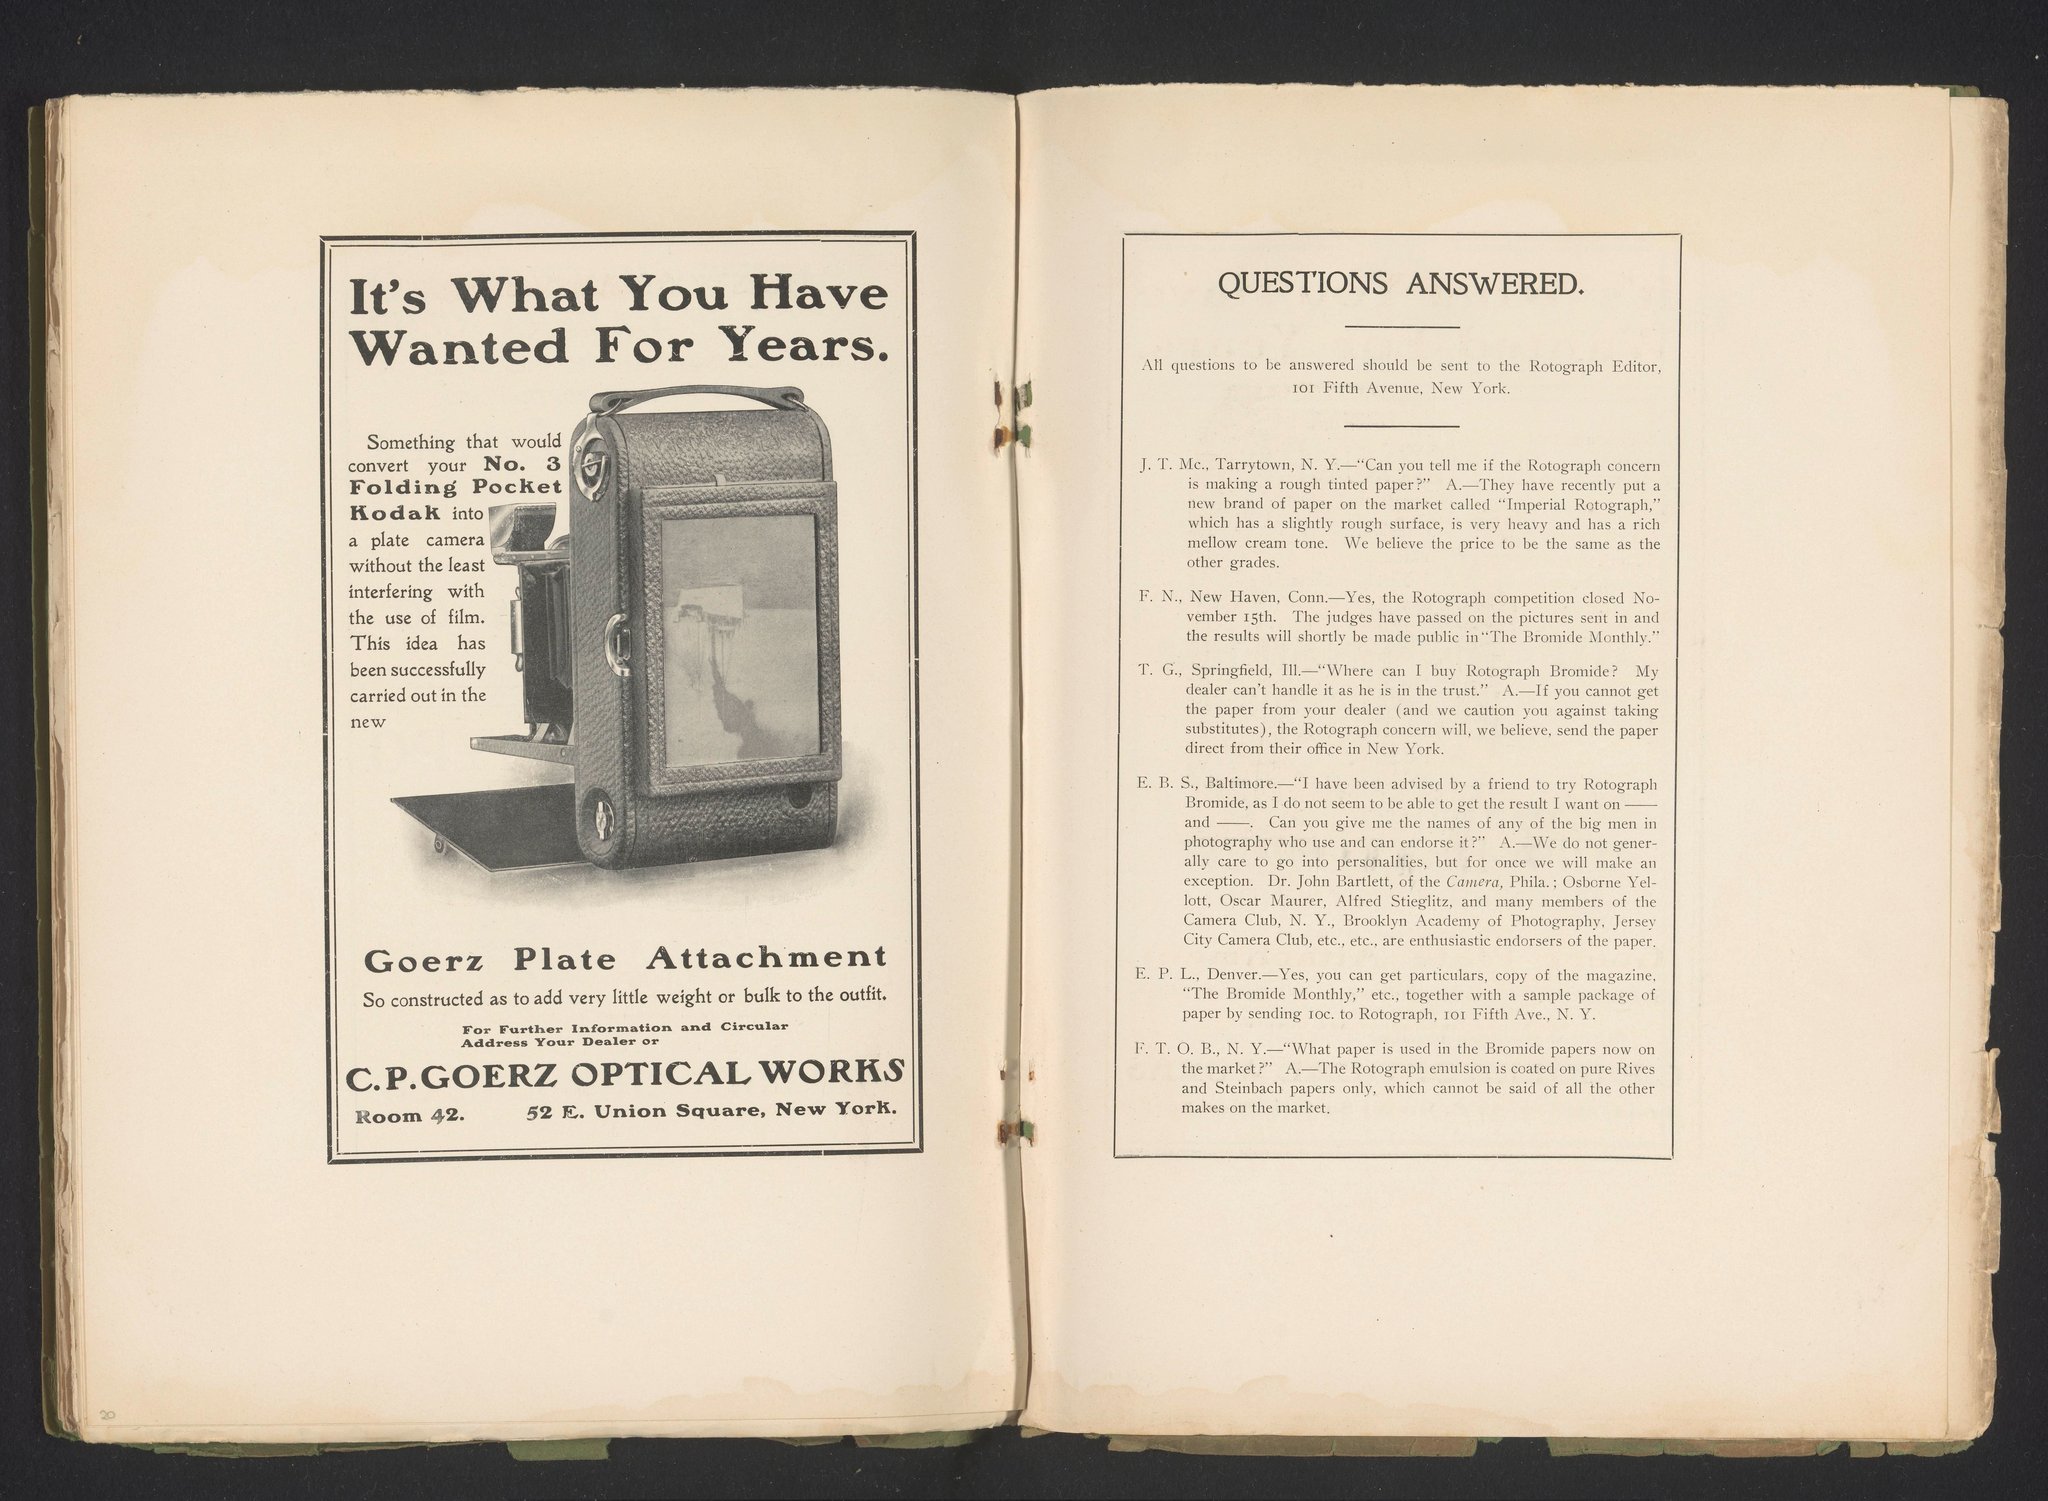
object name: photomechanical print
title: Gezicht op de achterzijde van een Kodak camera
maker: Anonymous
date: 1897-1902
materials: paper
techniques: autotype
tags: camera ~ photography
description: Prent in katern advertenties achterin boek. Prent is onderdeel van een reclameboodschap van C.P.Goerz Optical Works.